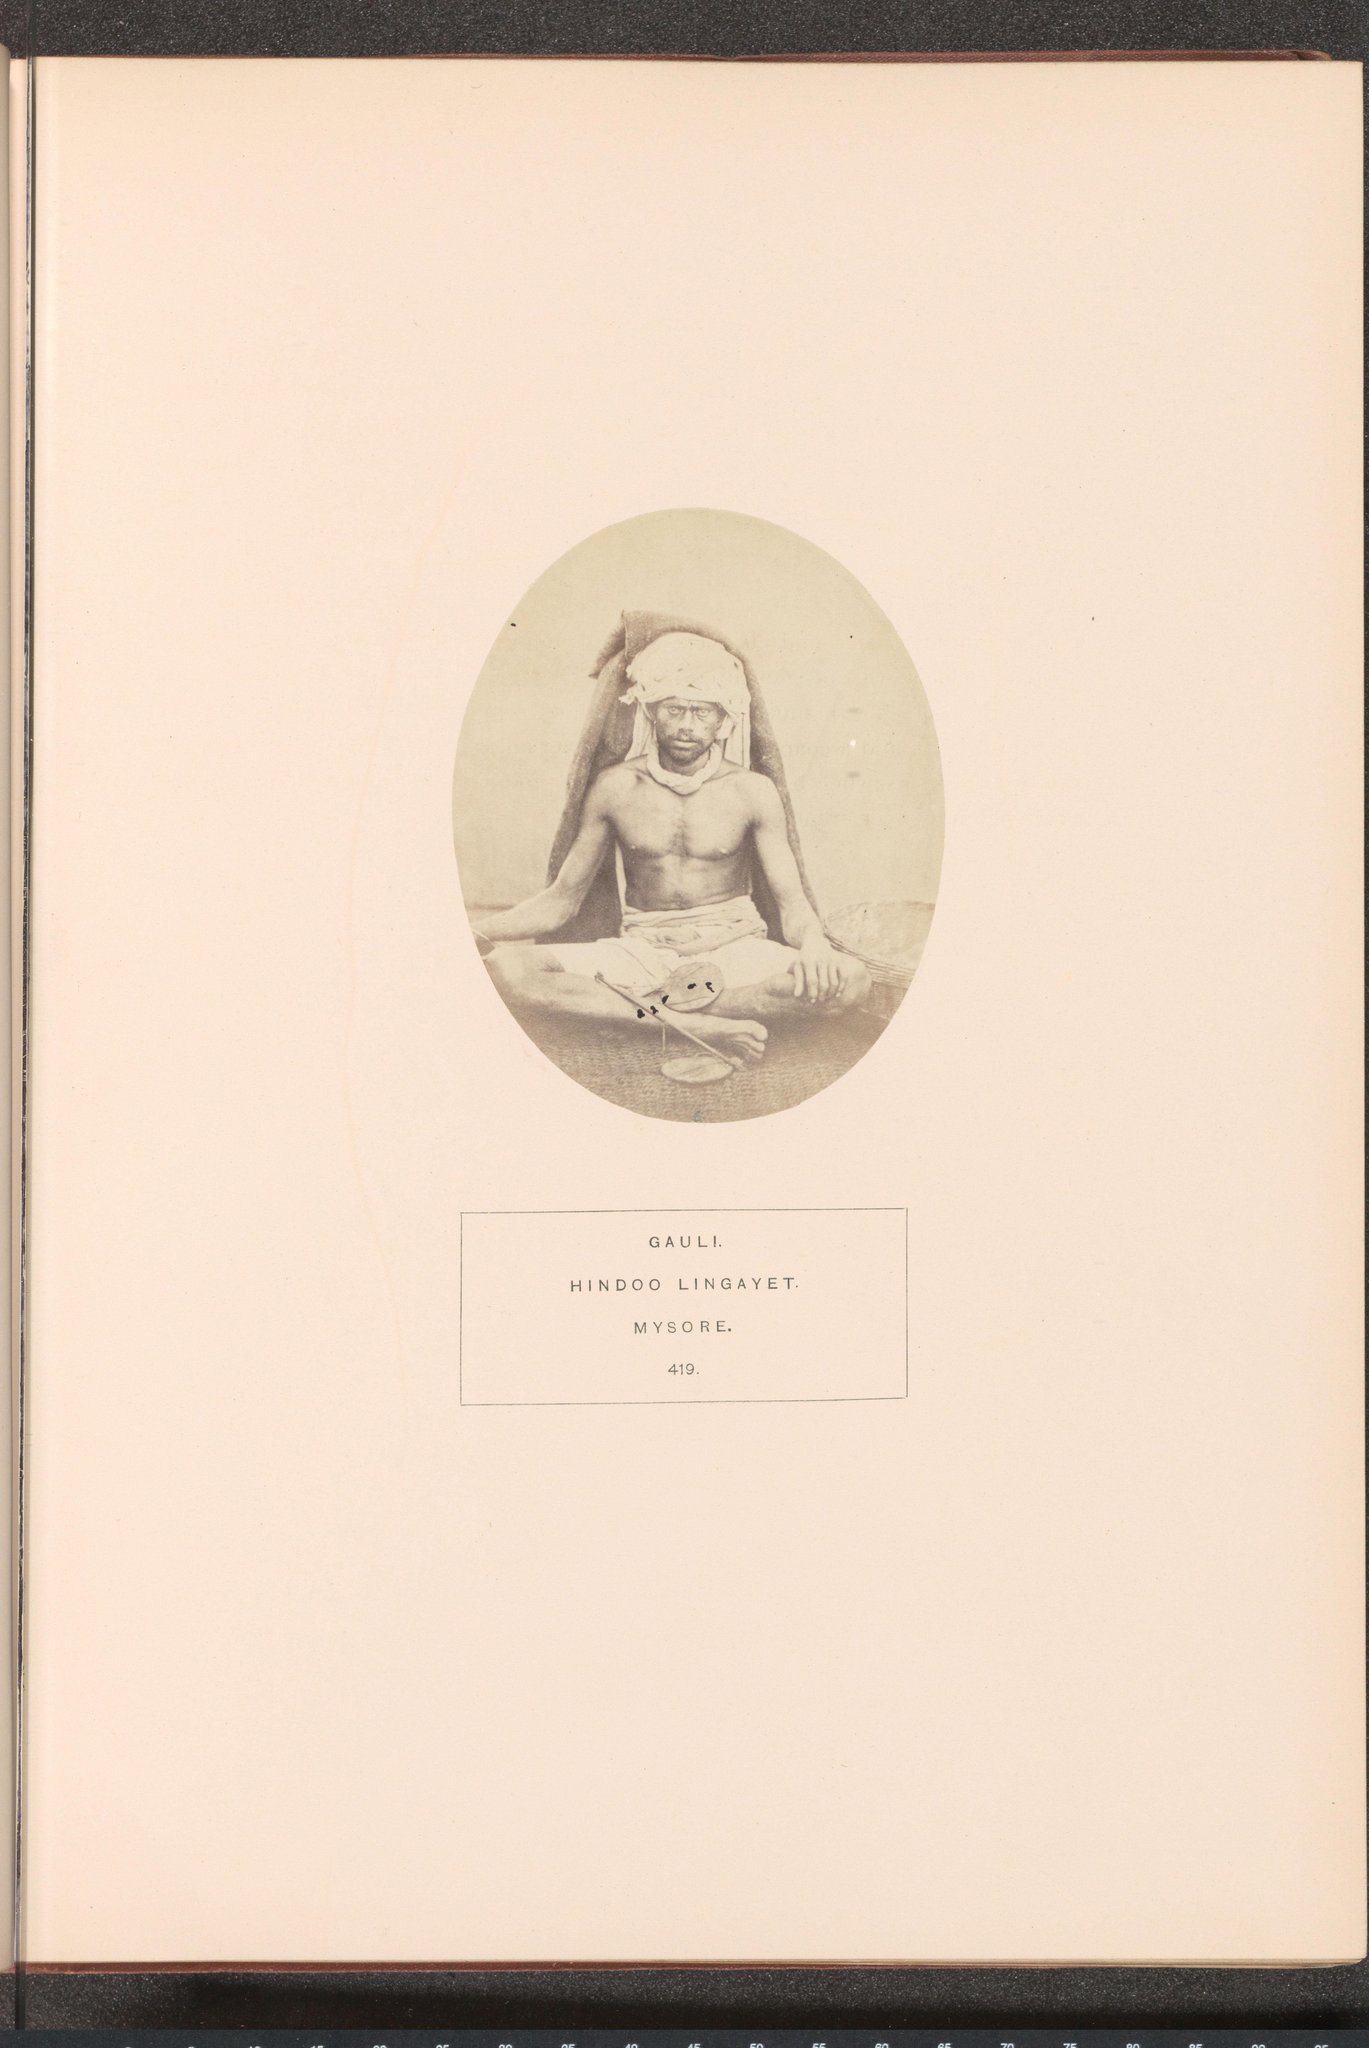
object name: photograph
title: Portrait of an unknown man from the Gawli community of Mysore, Karnataka, India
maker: Anonymous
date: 1865-1875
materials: photographic support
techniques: albumen print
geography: mysore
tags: head-gear: turban, human races; peoples; nationalities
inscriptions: inscription: ‘GAULI./ HINDOO LINGAYET./ MYSORE.’, number: ‘419.’